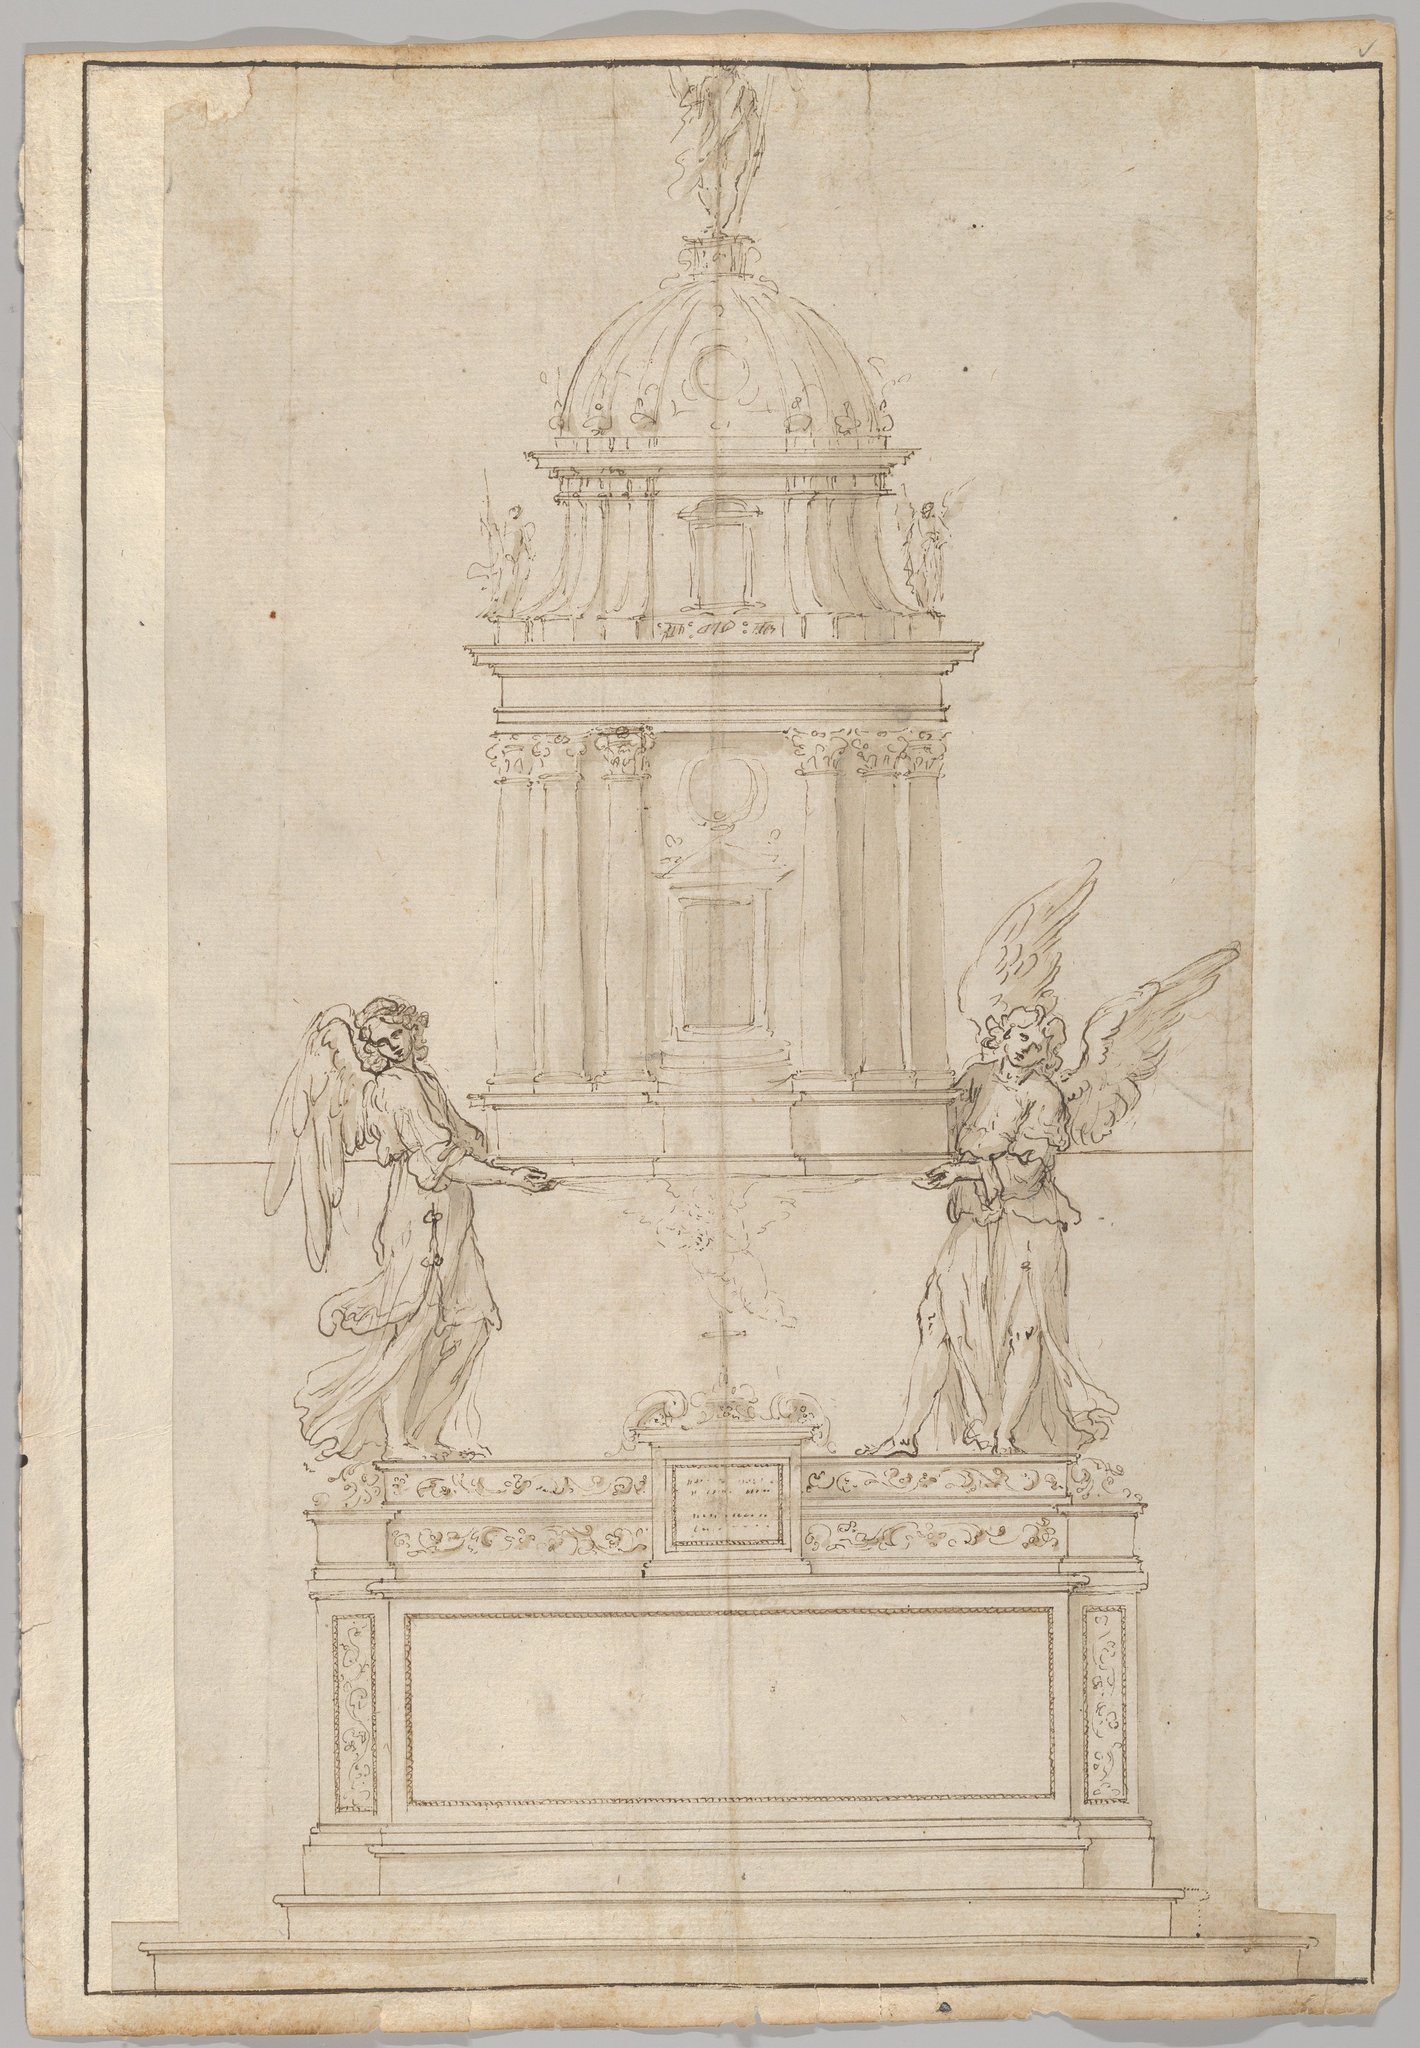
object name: drawing ornament architecture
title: Design for the Tabernacle of the Sistine Chapel in the Santa Maria Maggiore in Rome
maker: bastiano torrigiani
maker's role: former attribution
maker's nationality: italian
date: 1585-1590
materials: ink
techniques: pen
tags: tabernacles